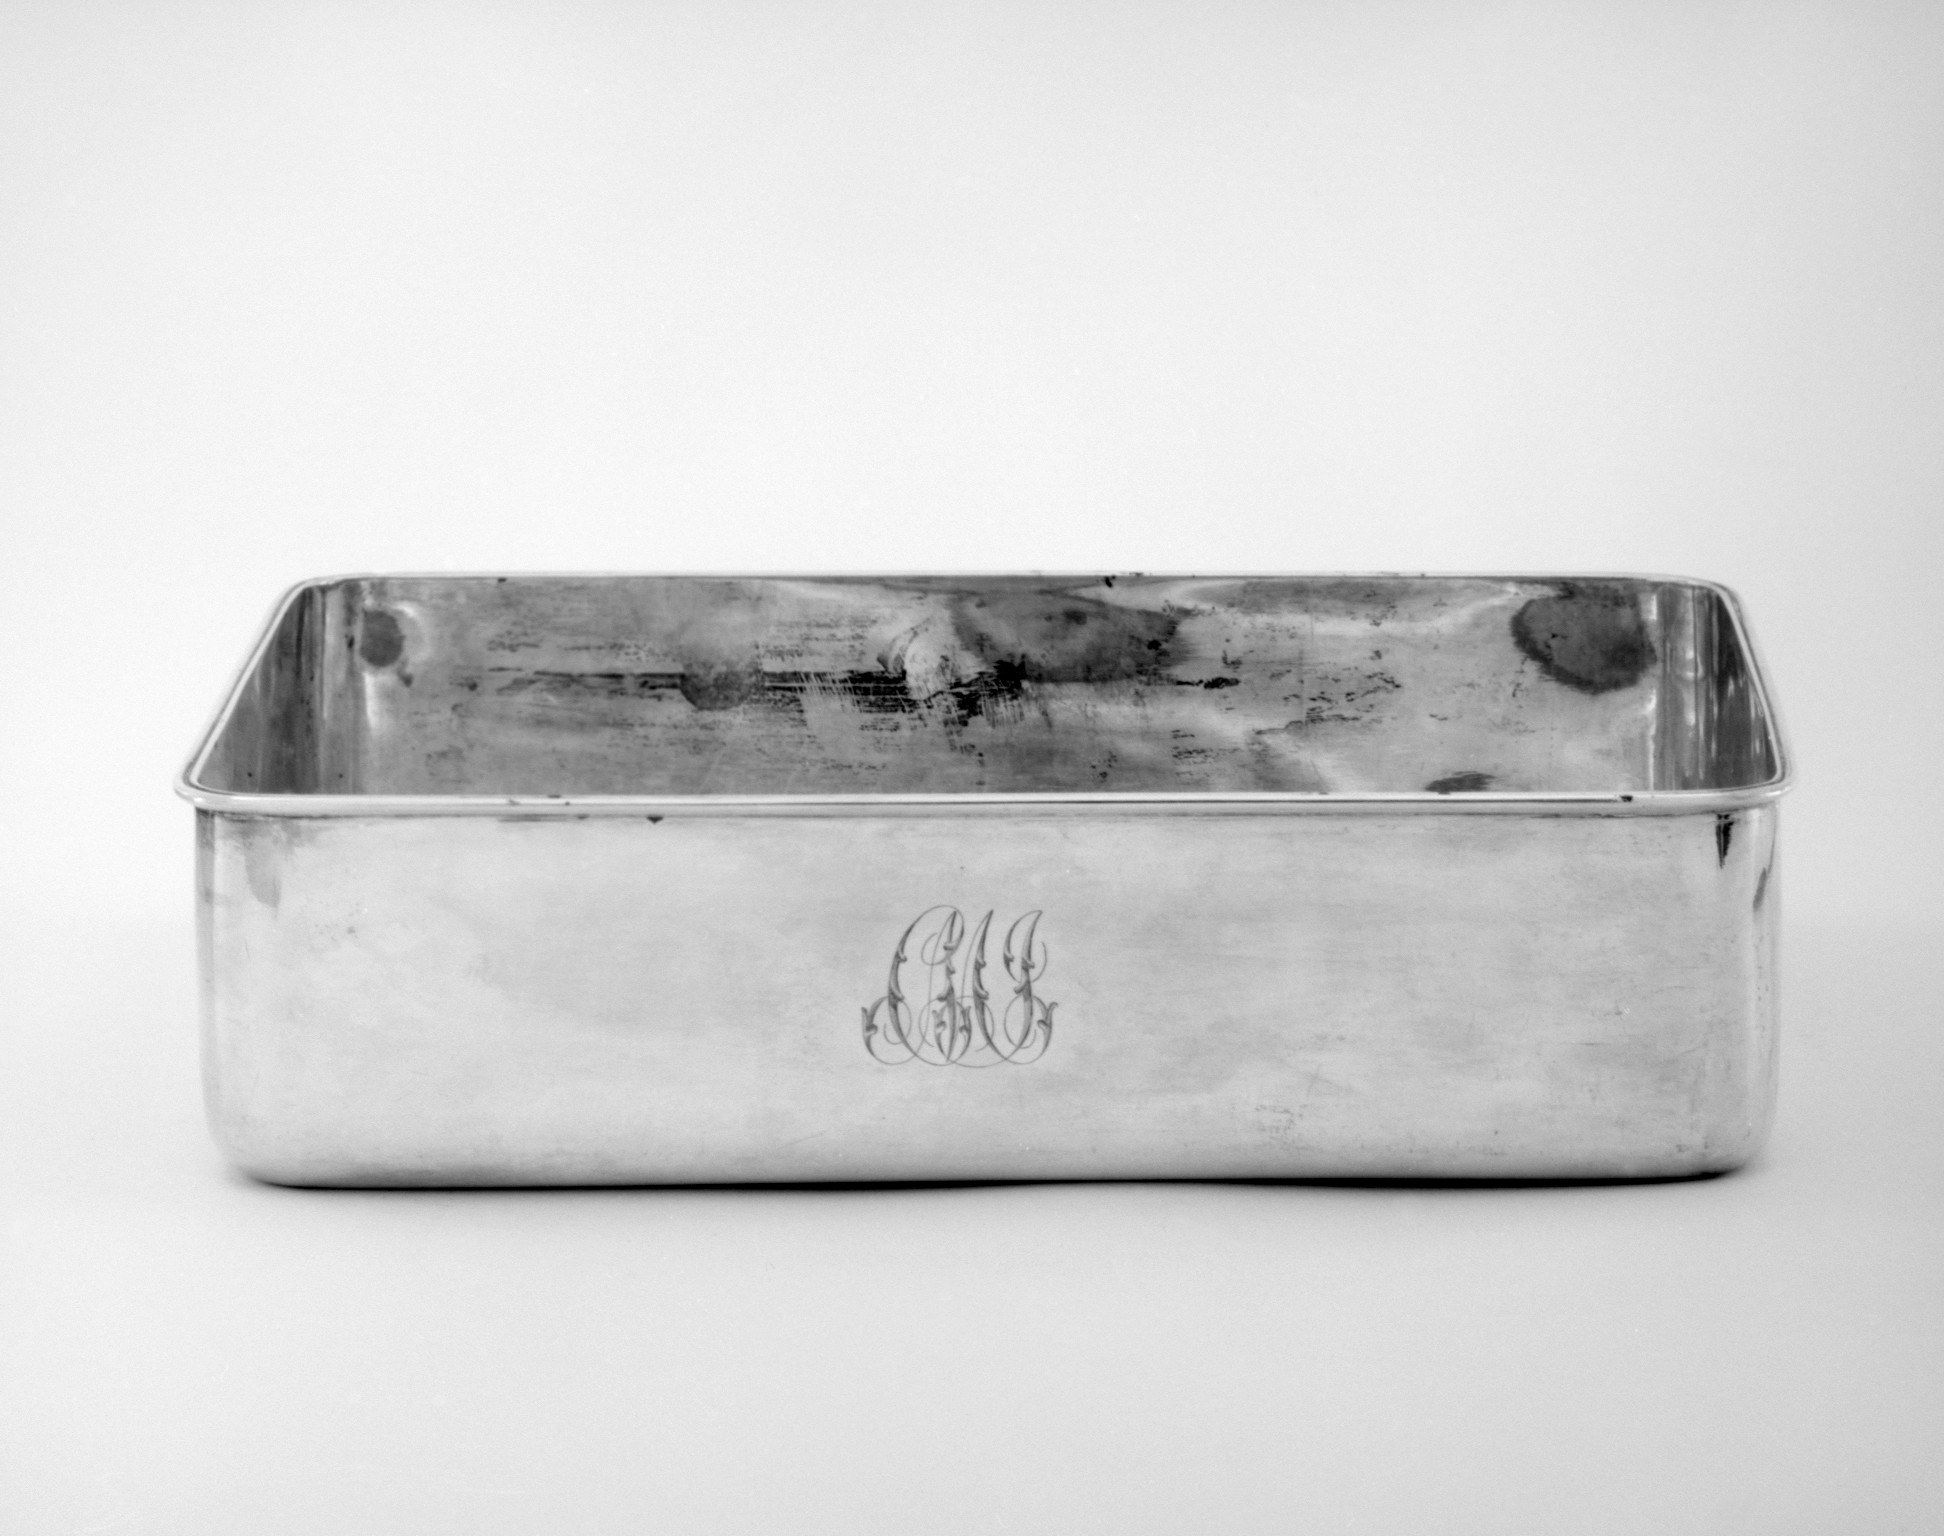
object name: basin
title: Basin (part of a set)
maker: anders lång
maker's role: maker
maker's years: 1843-1851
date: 1848-1849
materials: silver